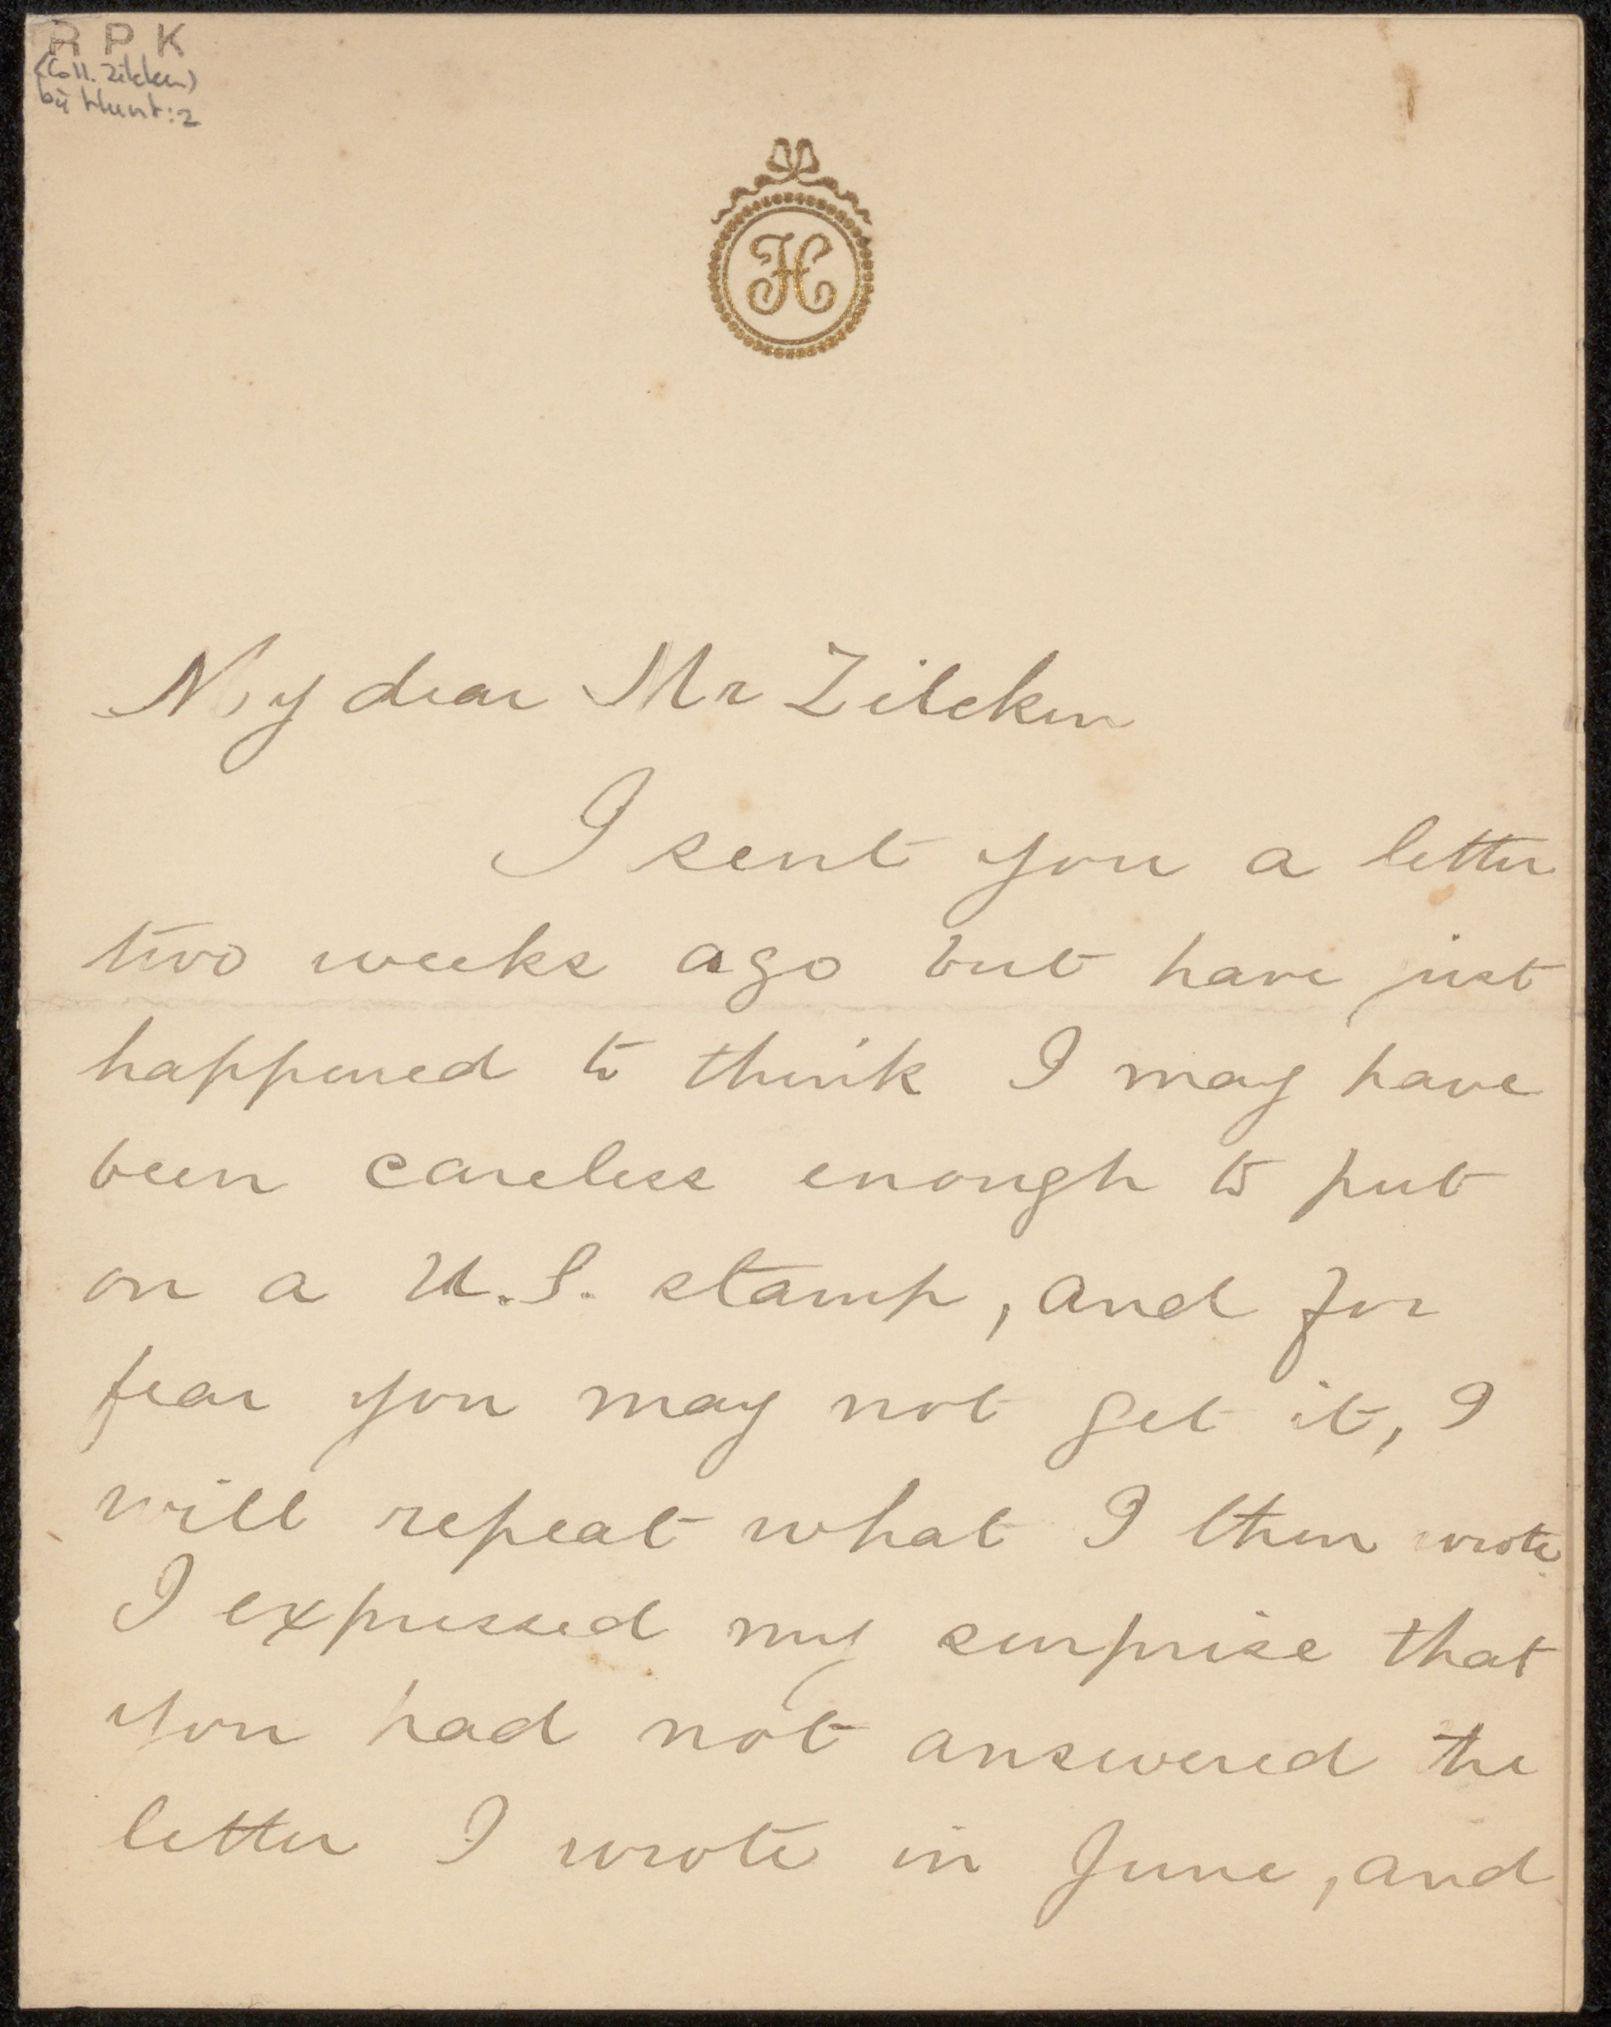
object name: letter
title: Brief aan Philip Zilcken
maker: alice hunt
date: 1867-1930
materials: ink, paper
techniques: pen, writing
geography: ann arbor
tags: painter, draughtsman, philip zilcken, art trade, art shop, the graphic arts, art collecting, new york (city)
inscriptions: collector's mark: ‘RPK’, initials: ‘H’